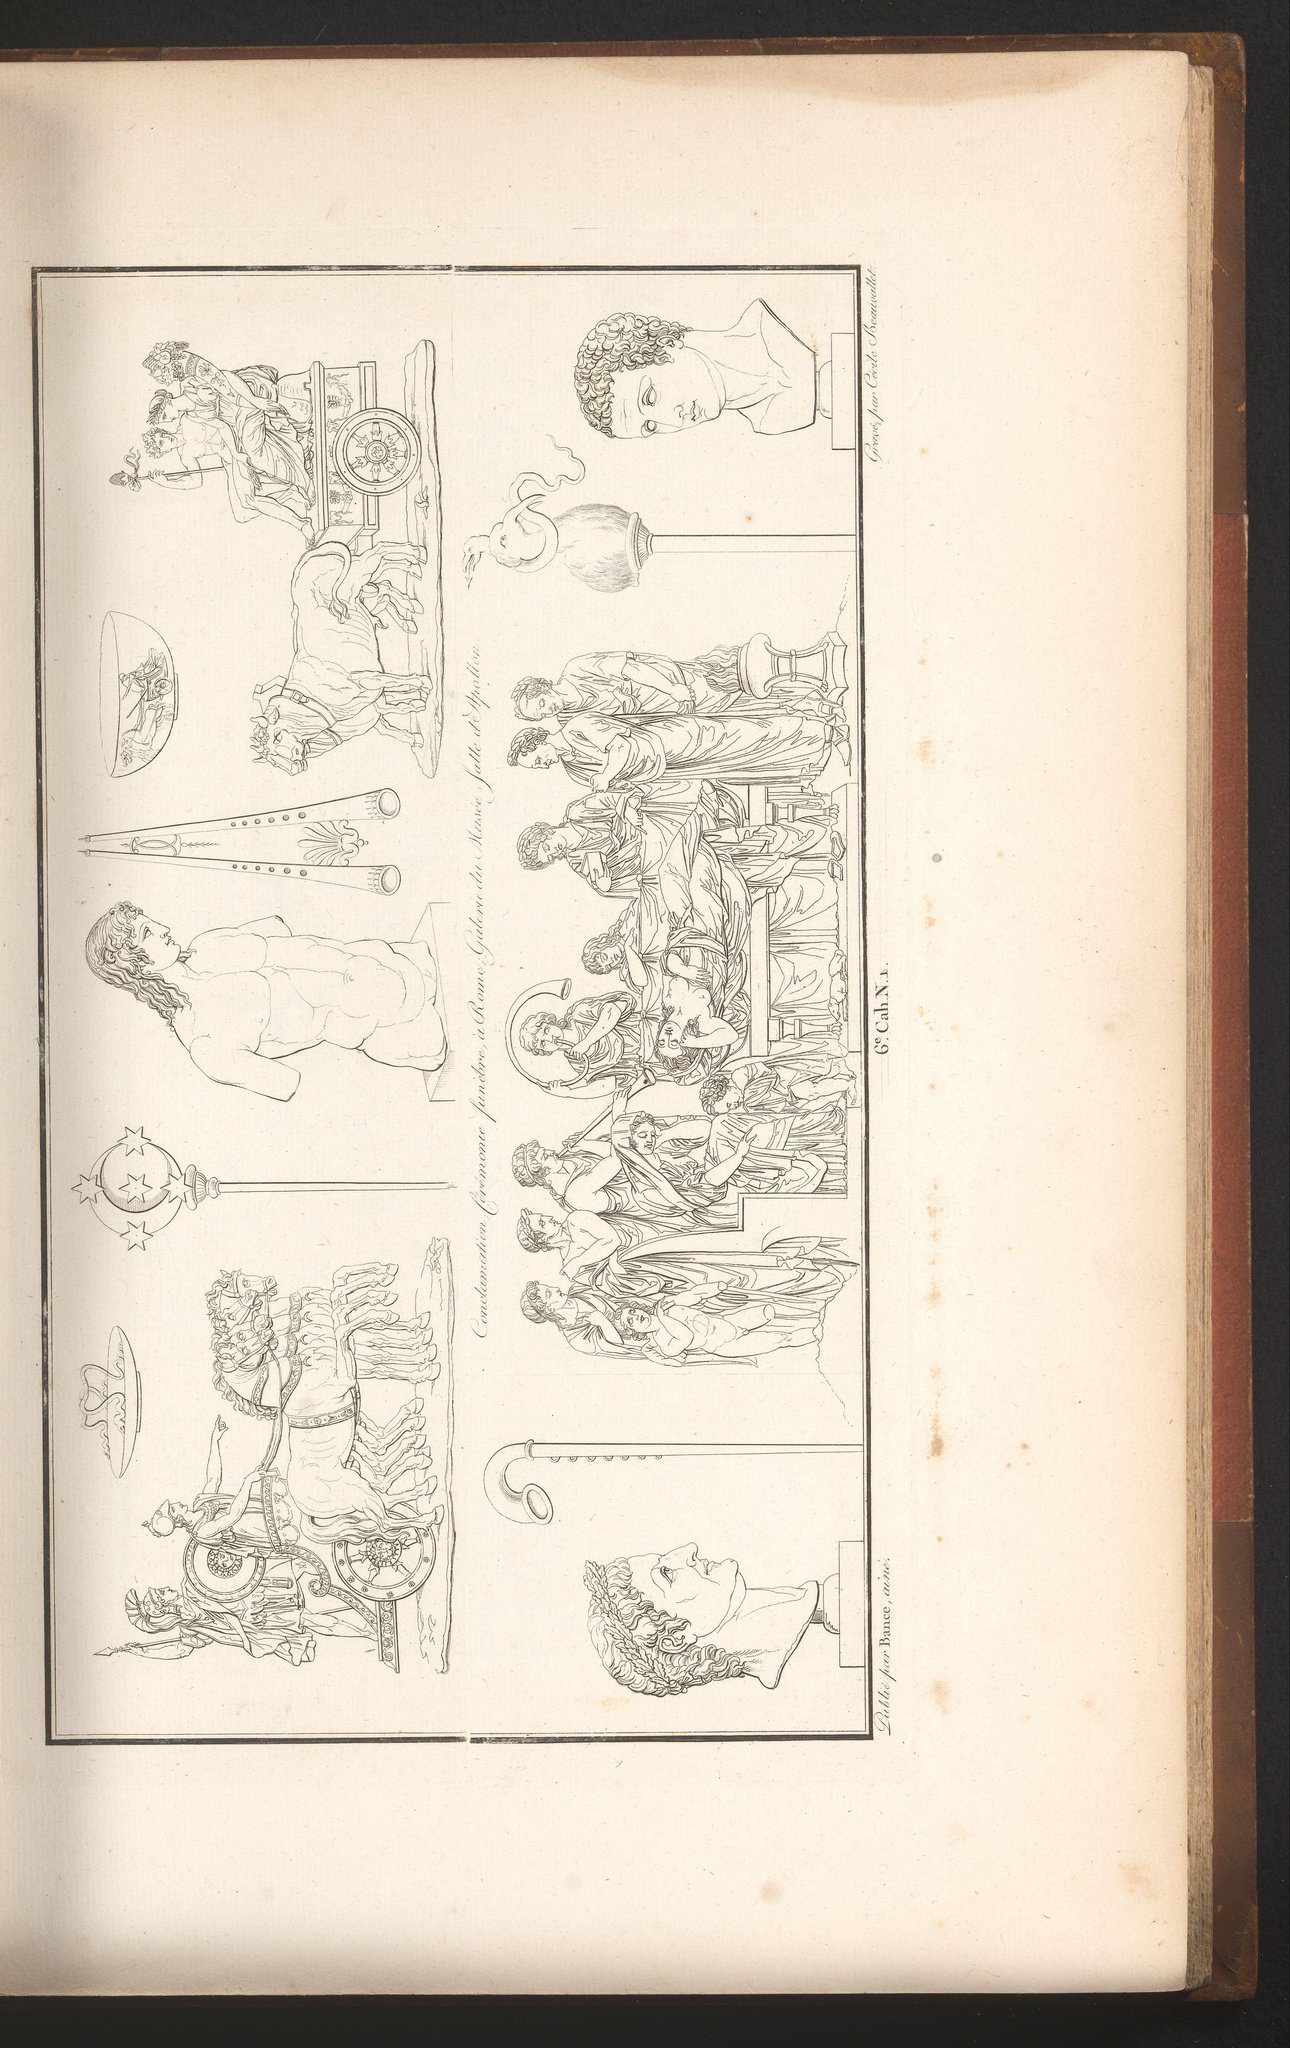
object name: ornament print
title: Begrafenisceremonie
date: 1820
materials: paper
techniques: etching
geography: paris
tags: ornaments ~ art, piece of sculpture, reproduction of a piece of sculpture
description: Ornamentprent met o.a. een begrafenisceremonie, een strijdwagen en portretbustes. Onderdeel (6e. Cah. N. 1) van het prentalbum met twee series van in totaal 138 ornamentprenten door Beauvallet en Normand, 'Fragmens d'Ornemens dans le Style Antique'.